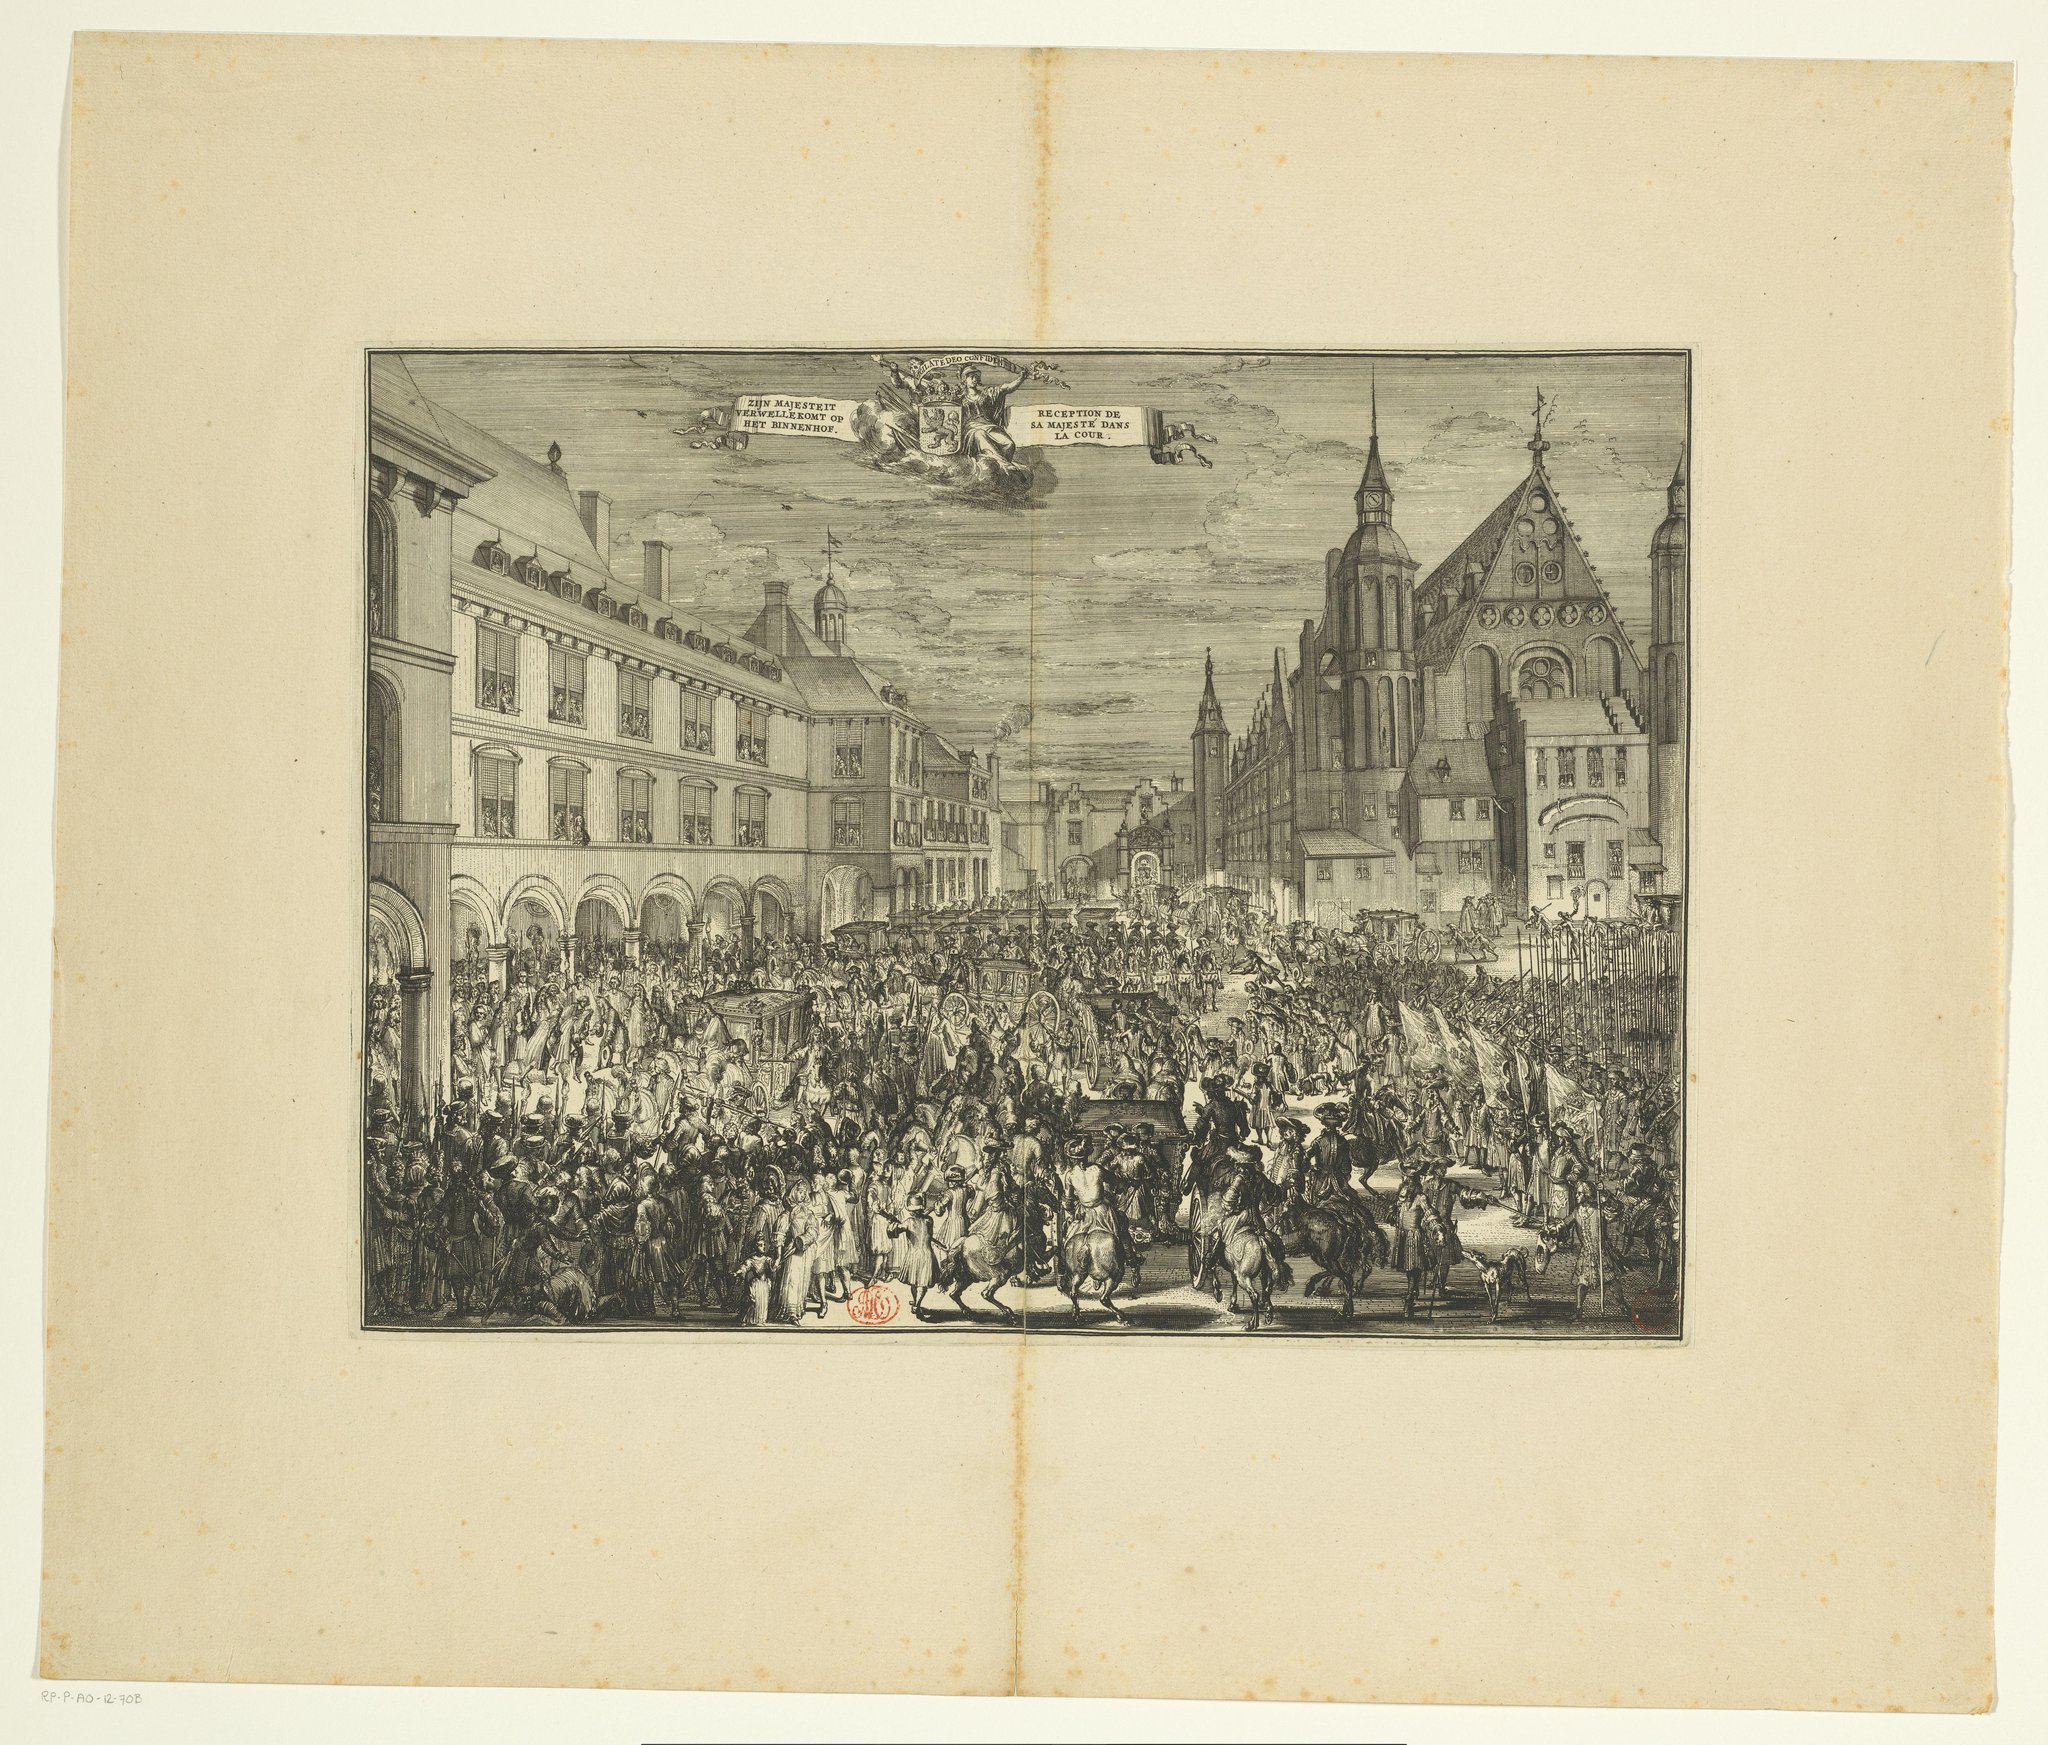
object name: print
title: Zijn majesteit verwellekomt op het Binnenhof / Reception de sa majesté dans la cour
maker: romeyn de hooghe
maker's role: draughtsman, goldsmith, painter, print maker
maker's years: 1645-1708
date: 1691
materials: paper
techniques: etching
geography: northern netherlands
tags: the hague, william iii (prince of orange and king of england, scotland, and ireland), triumphal entry and public reception, pageant, 'entrée solennelle', 'joyeuse entrée'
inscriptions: collector's mark: Lugt 195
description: Prent ook gebruikt in: Bidloo, Govard. Komste van zyne majesteit Willem III. Koning van Groot Britanje, enz. in Holland; ofte omstandelyke beschryving van alles, (…) vercierd met kopere plaaten. Den Haag: Arnoud Leers, 1691.